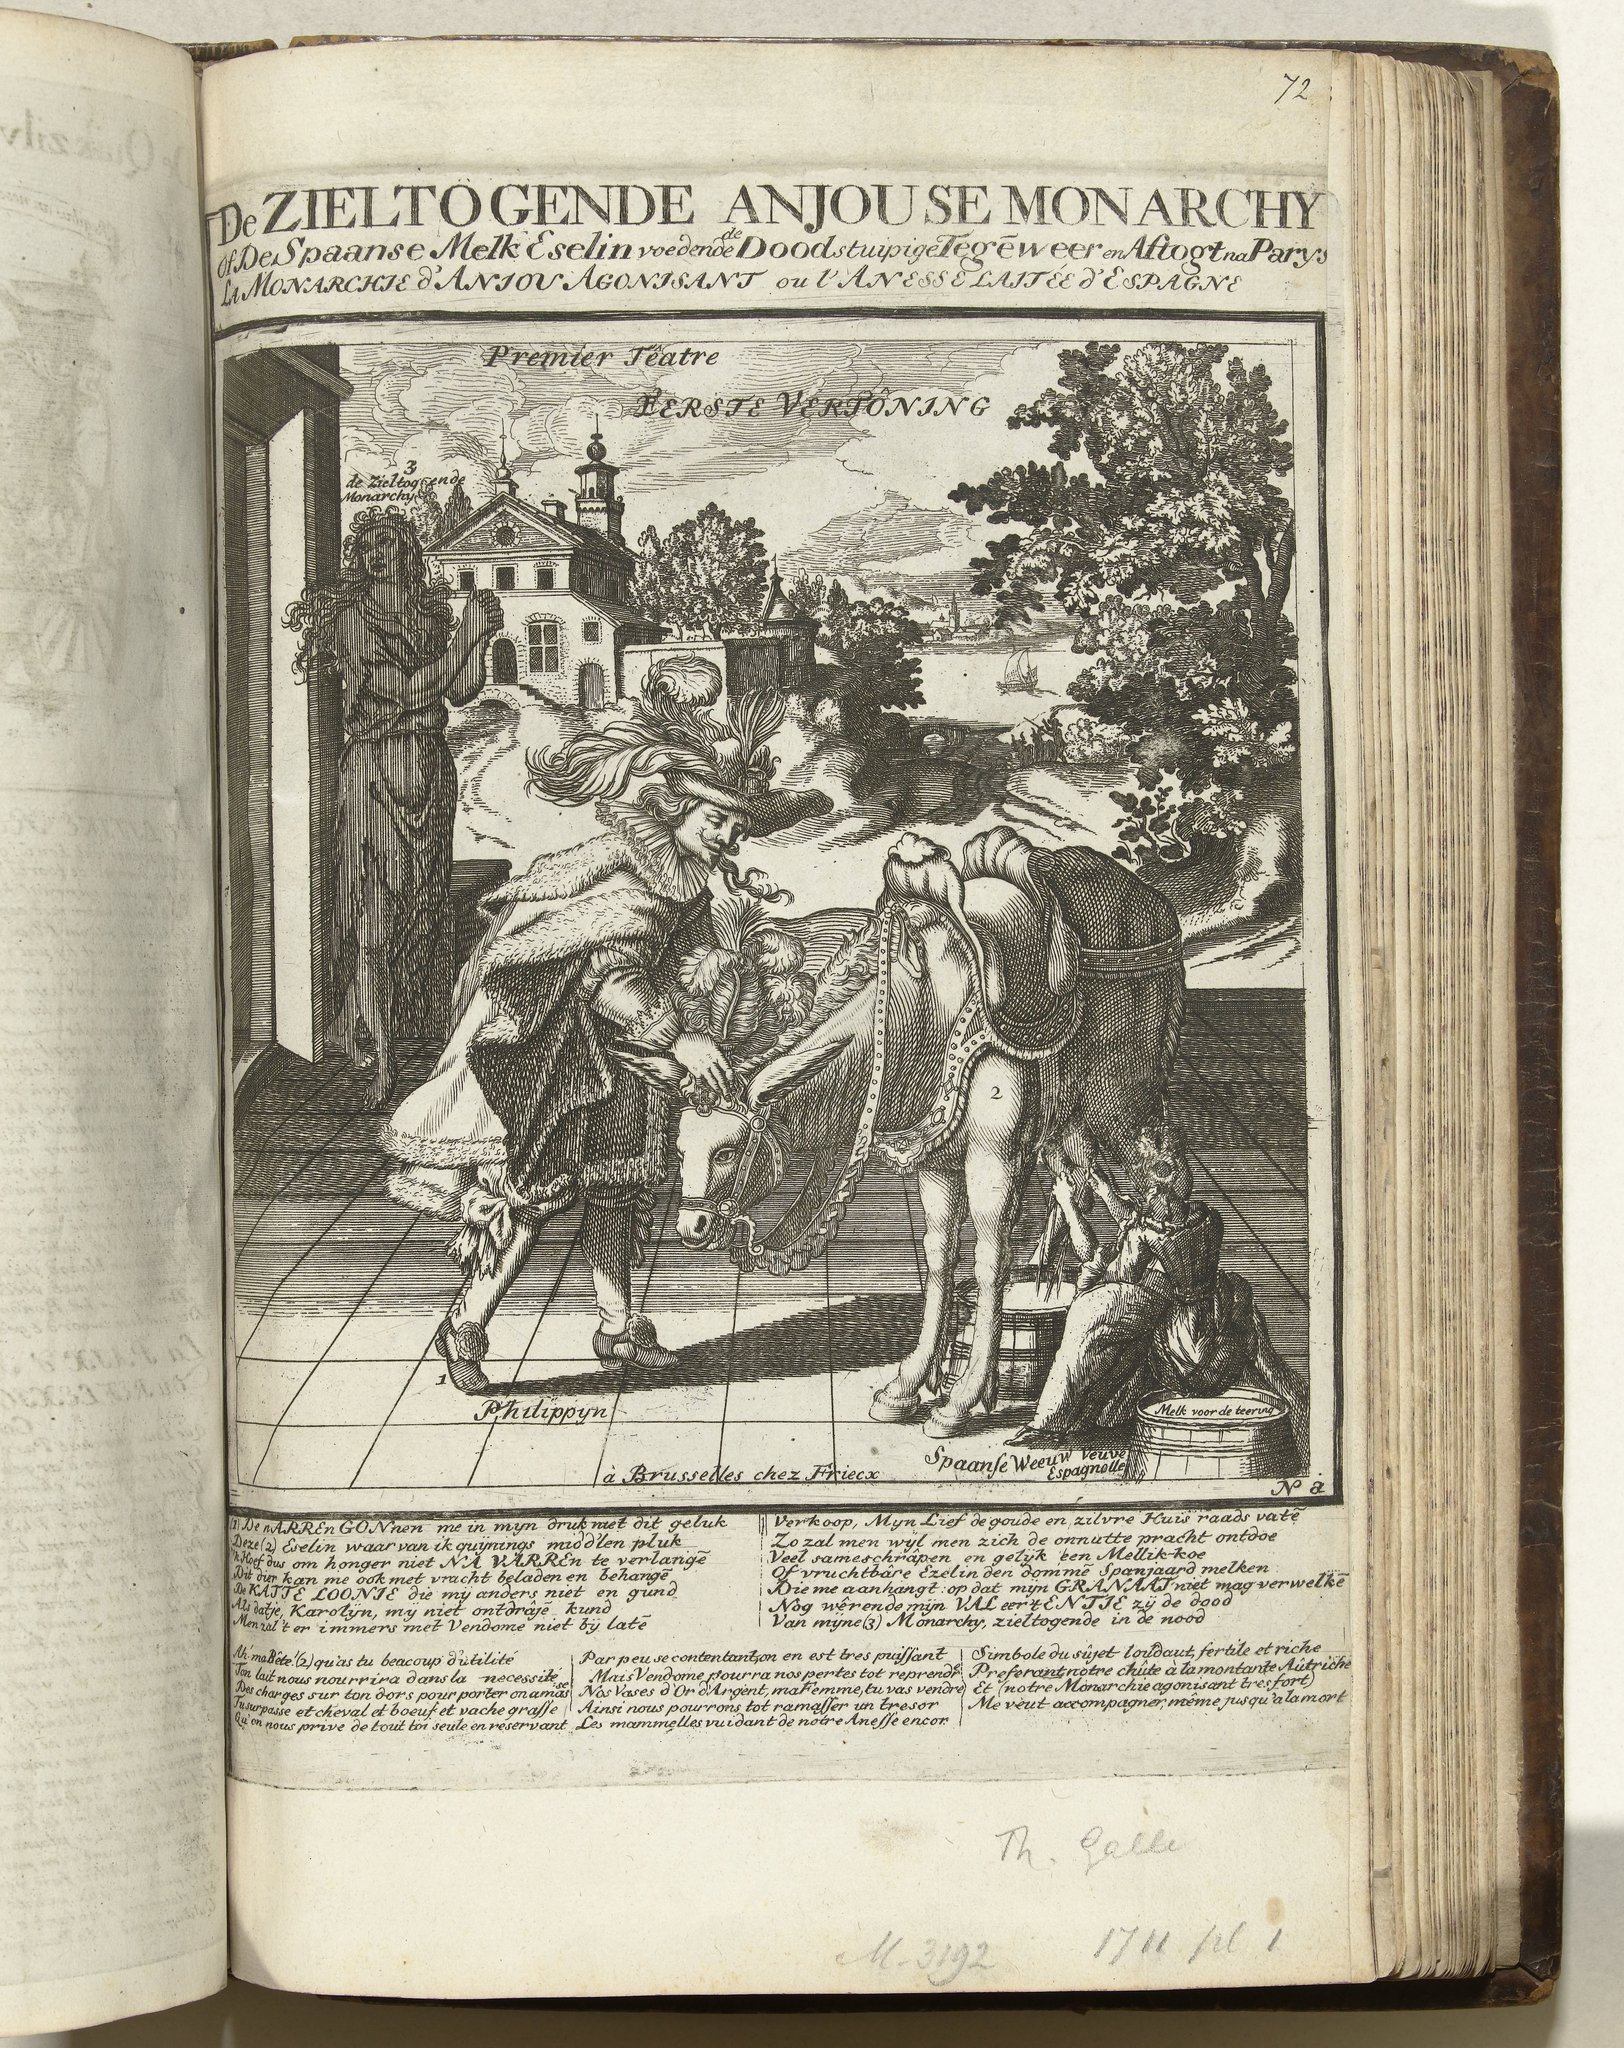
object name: cartoon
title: De Zieltogende Anjouse Monarchy Of De Spaanse Melk Eselin voedende de Doodstuipige Tege[n]weer en Aftogt na Parys / La Monarchie Anjou Agonisant (...)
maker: abraham allard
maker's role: print maker, publisher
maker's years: 1676-1725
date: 1711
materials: paper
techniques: engraving, etching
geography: amsterdam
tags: filips v (koning van spanje), political caricatures and satires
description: De zieltogende Anjouse Monarchie (plaat a), 1711. Eerste plaat in een groep van 4 allegorieën op het falen van de hertog van Anjou als koning Filips V van Spanje. De ezel (Spanje) wordt gemolken. Met opschriften en verzen in het Nederlands en Frans. Onderdeel van de Platen over 1711, een groep van 5 ongenummerde spotprenten op de Fransen in het jaar 1711 van de Spaanse Successieoorlog. Onderdeel van het prentwerk uitgegeven onder de verzameltitel 't Lust-Hof van Momus met de gebundelde series van spotprenten tijdens de jaren 1701-1713 van de Spaanse Successieoorlog.